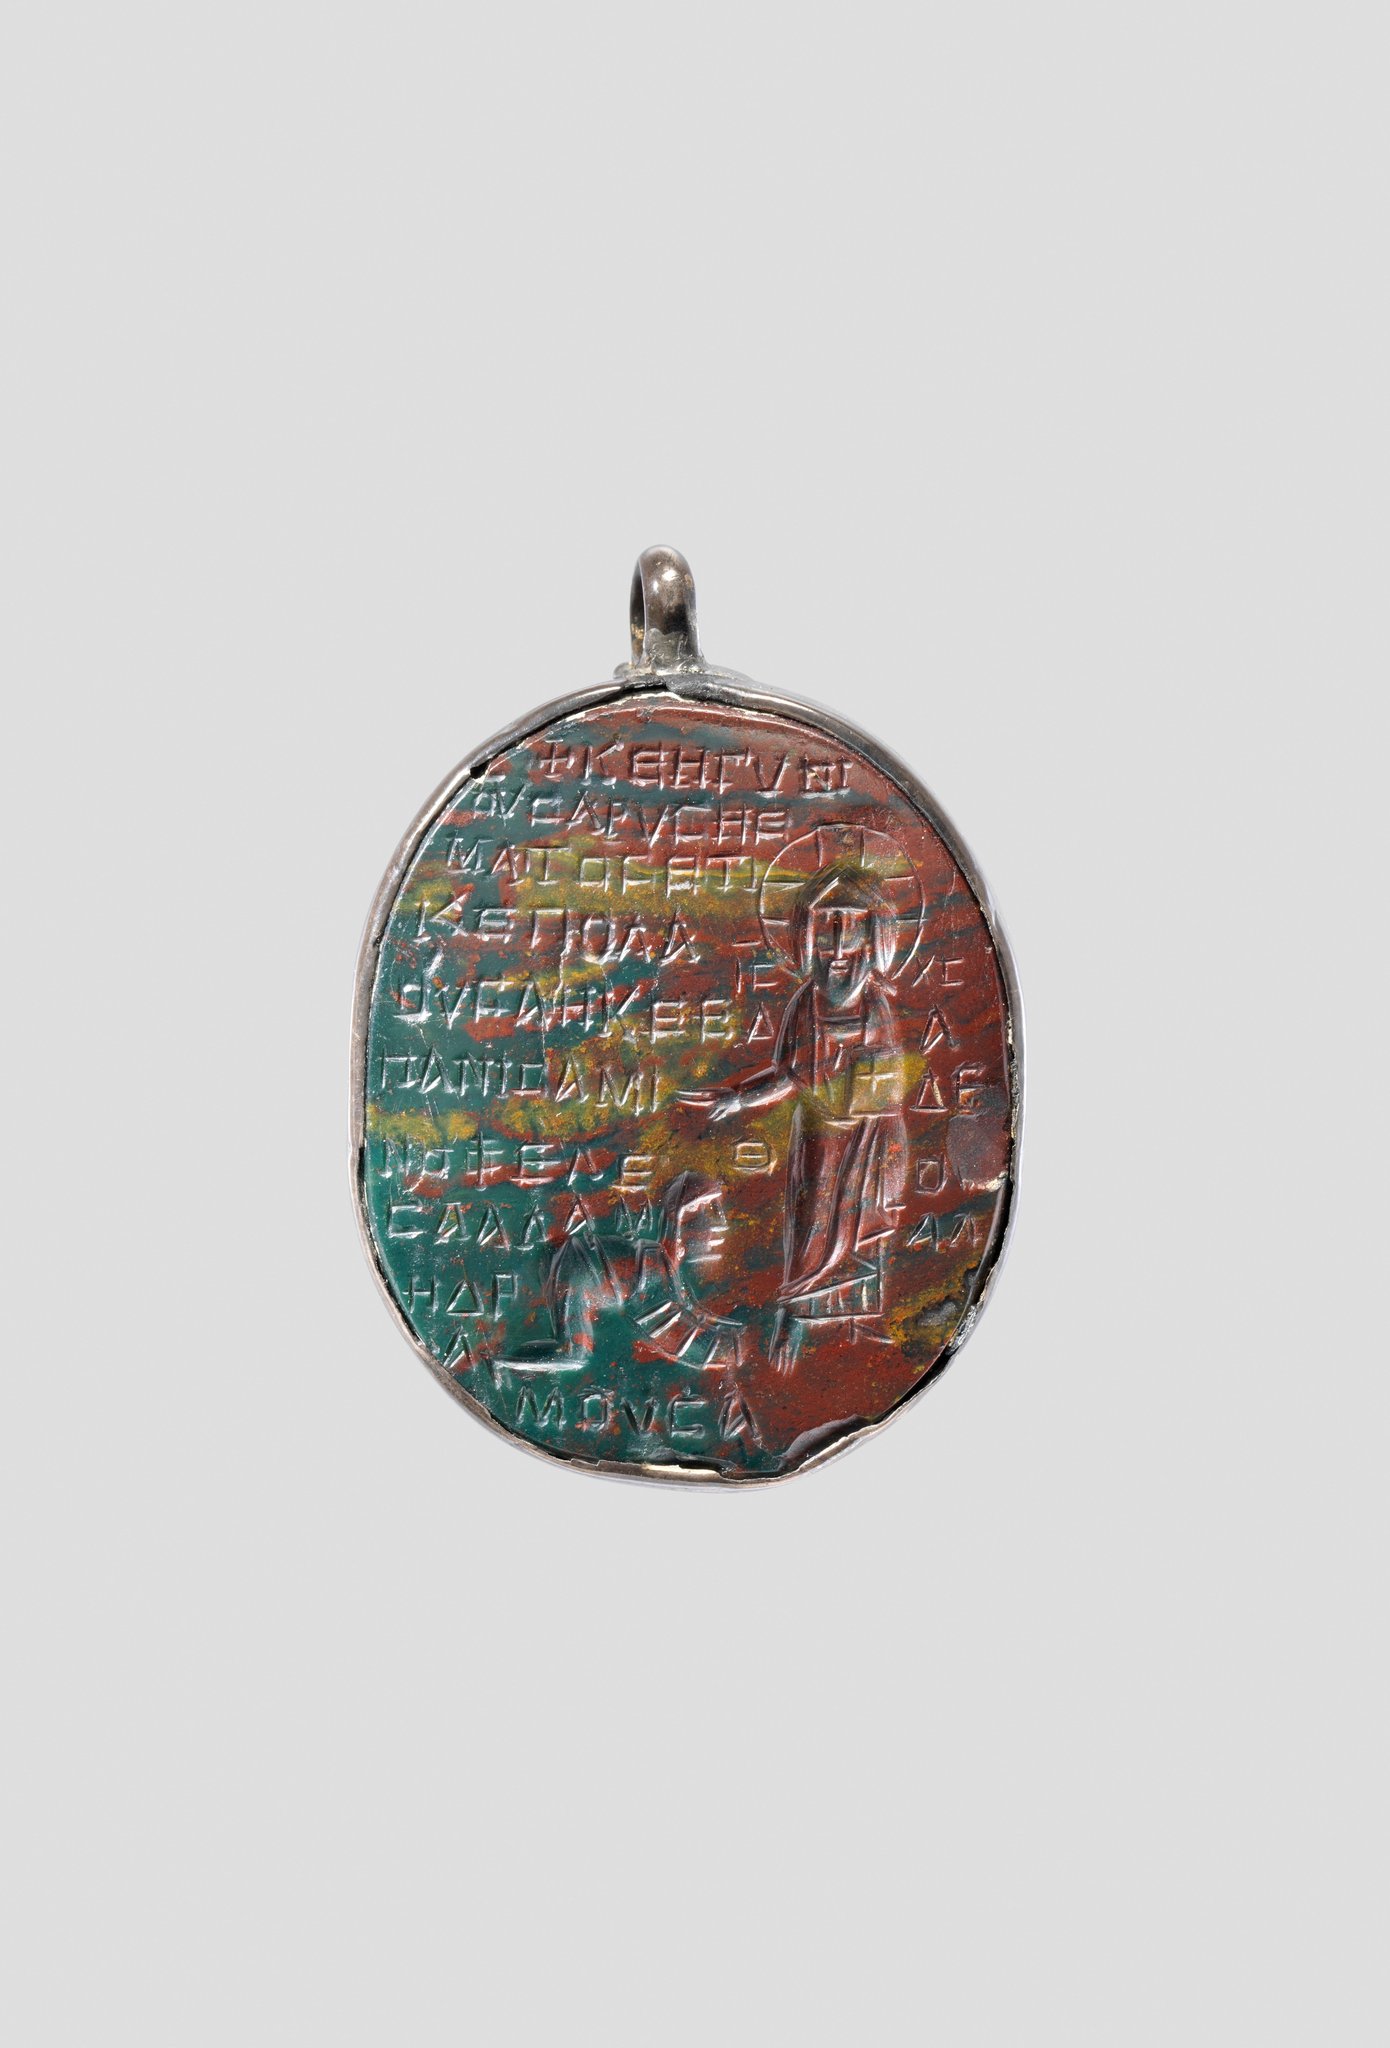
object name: necklace, bead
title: Amulet Carved in Intaglio (Incised)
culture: byzantine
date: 501-700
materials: mineral, silver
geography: egypt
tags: women,christ